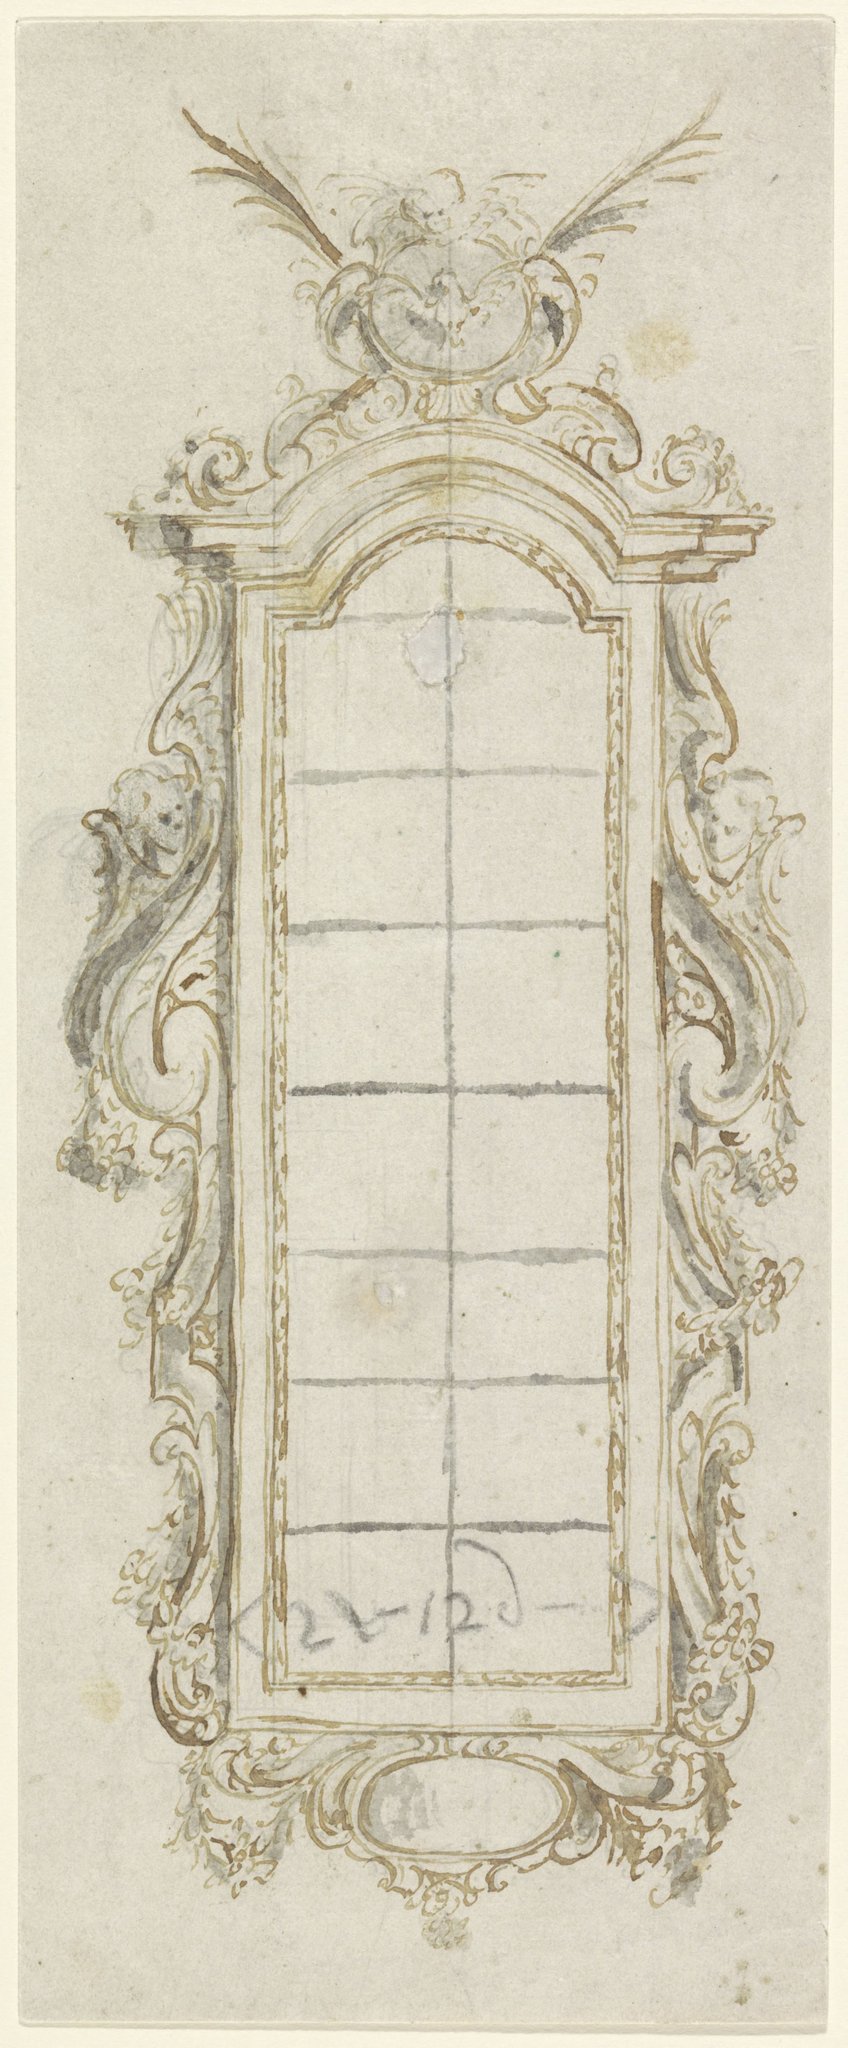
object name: ornamenttekening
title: Raamomlijsting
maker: Anonymous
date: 1600-1800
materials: ink, paper, pencil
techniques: brush, pen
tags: window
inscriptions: collector's mark: Lugt 2228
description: Een ornamentele raamomlijsting, bekroond met een putto en een duif als symbool van de Heilige Geest.